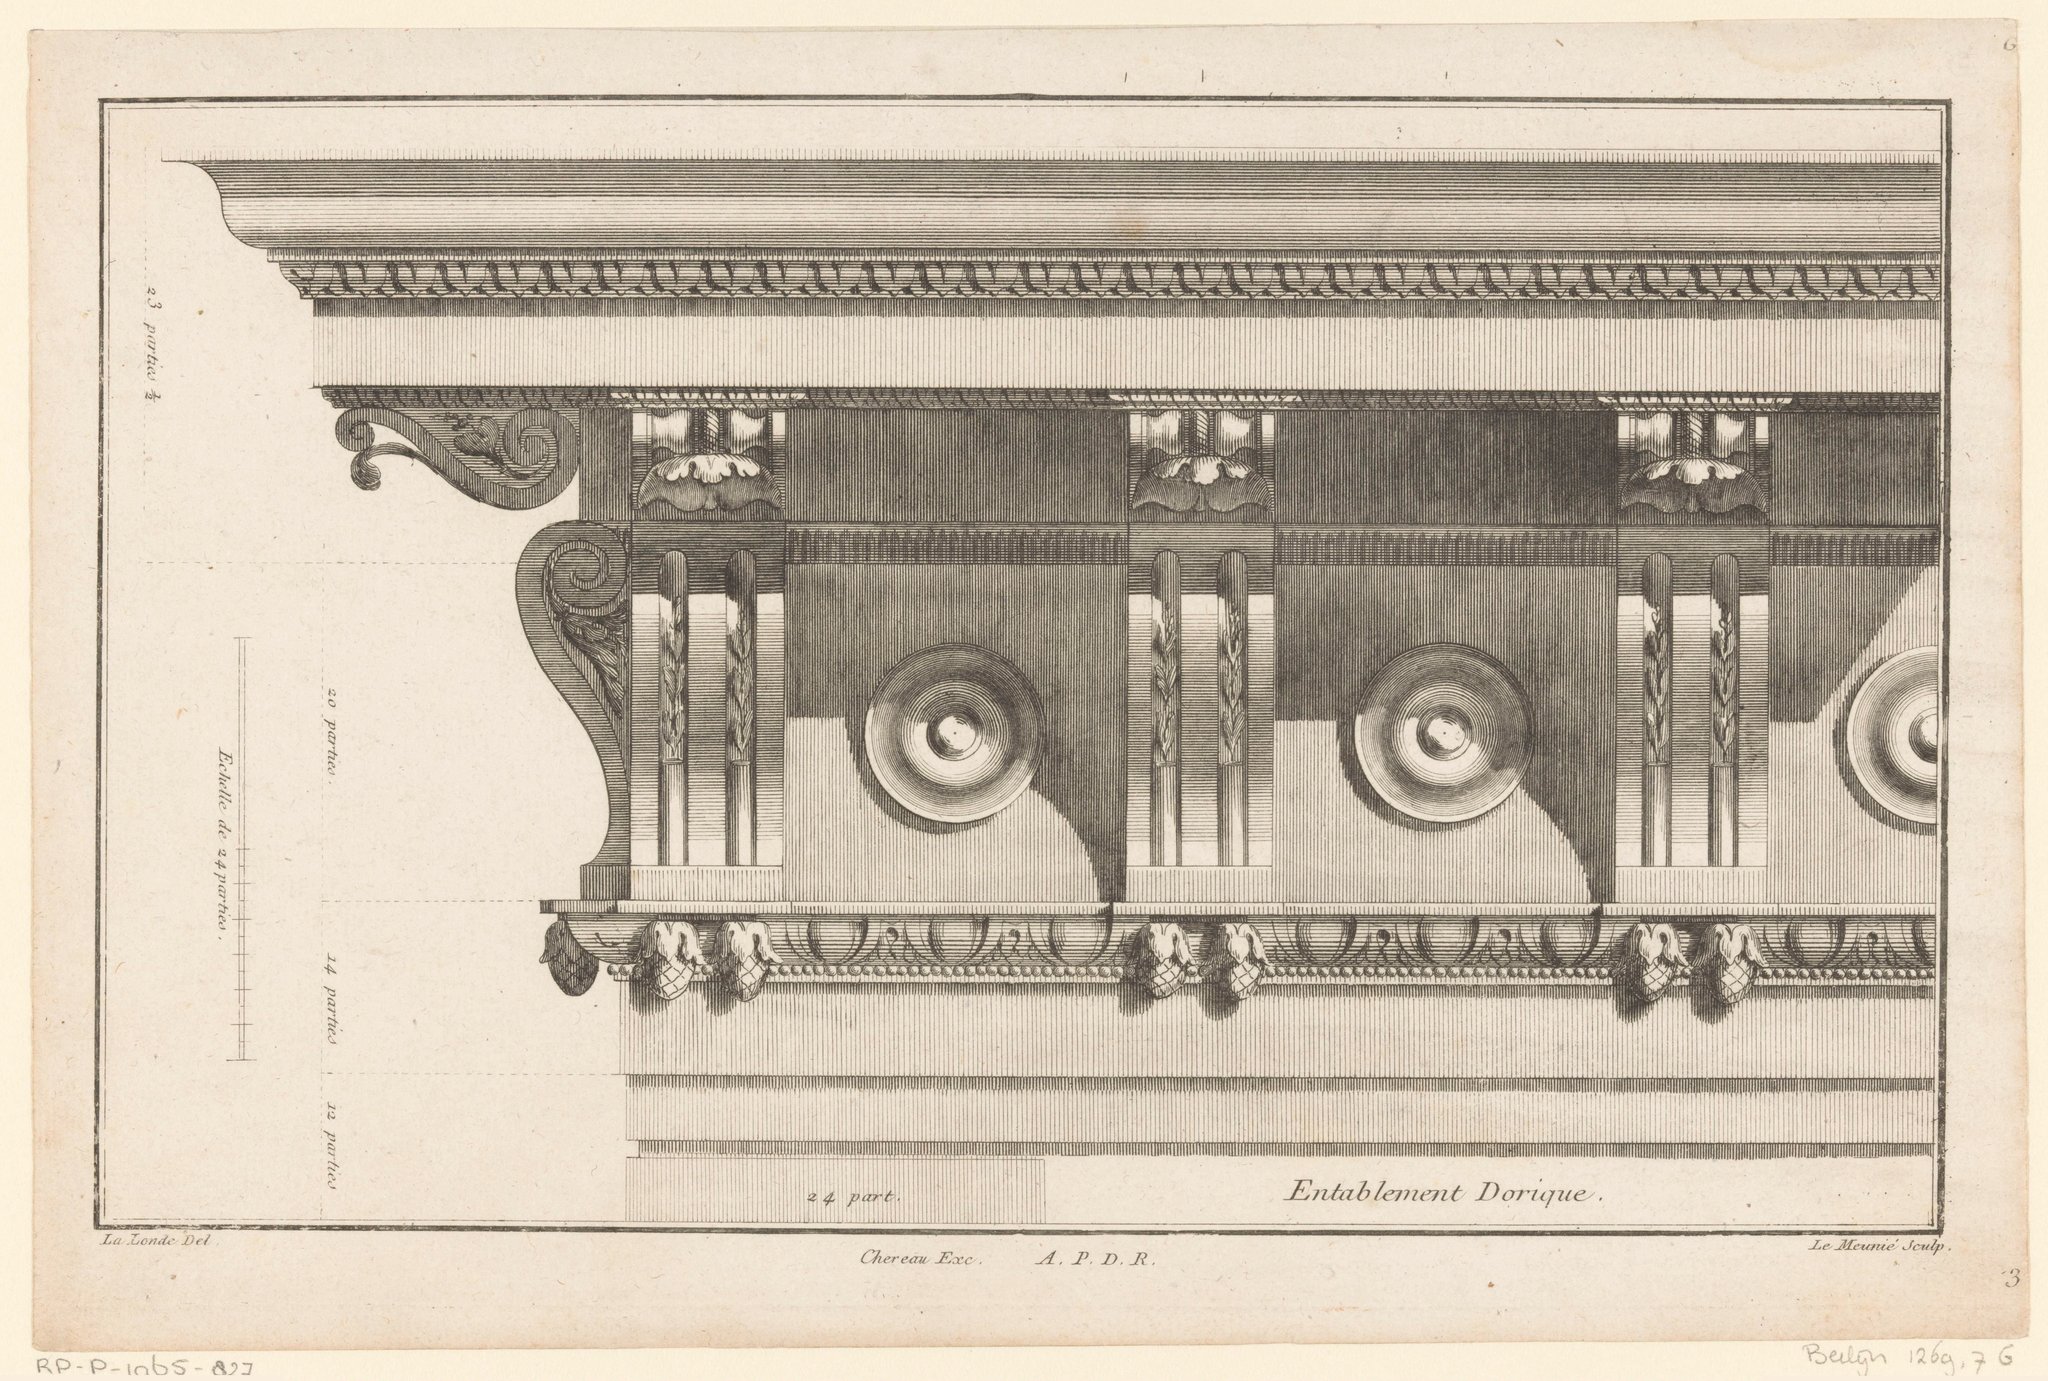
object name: ornament print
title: Dorisch hoofdgestel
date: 1784-1785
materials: paper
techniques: engraving, etching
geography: paris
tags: doric order ~ architecture, other architectural details (entablature)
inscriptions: collector's mark: Lugt 2228, collector's mark: Lugt 2760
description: Een Dorisch hoofdgestel met ronde elementen, een eierlijst en dennenappels.